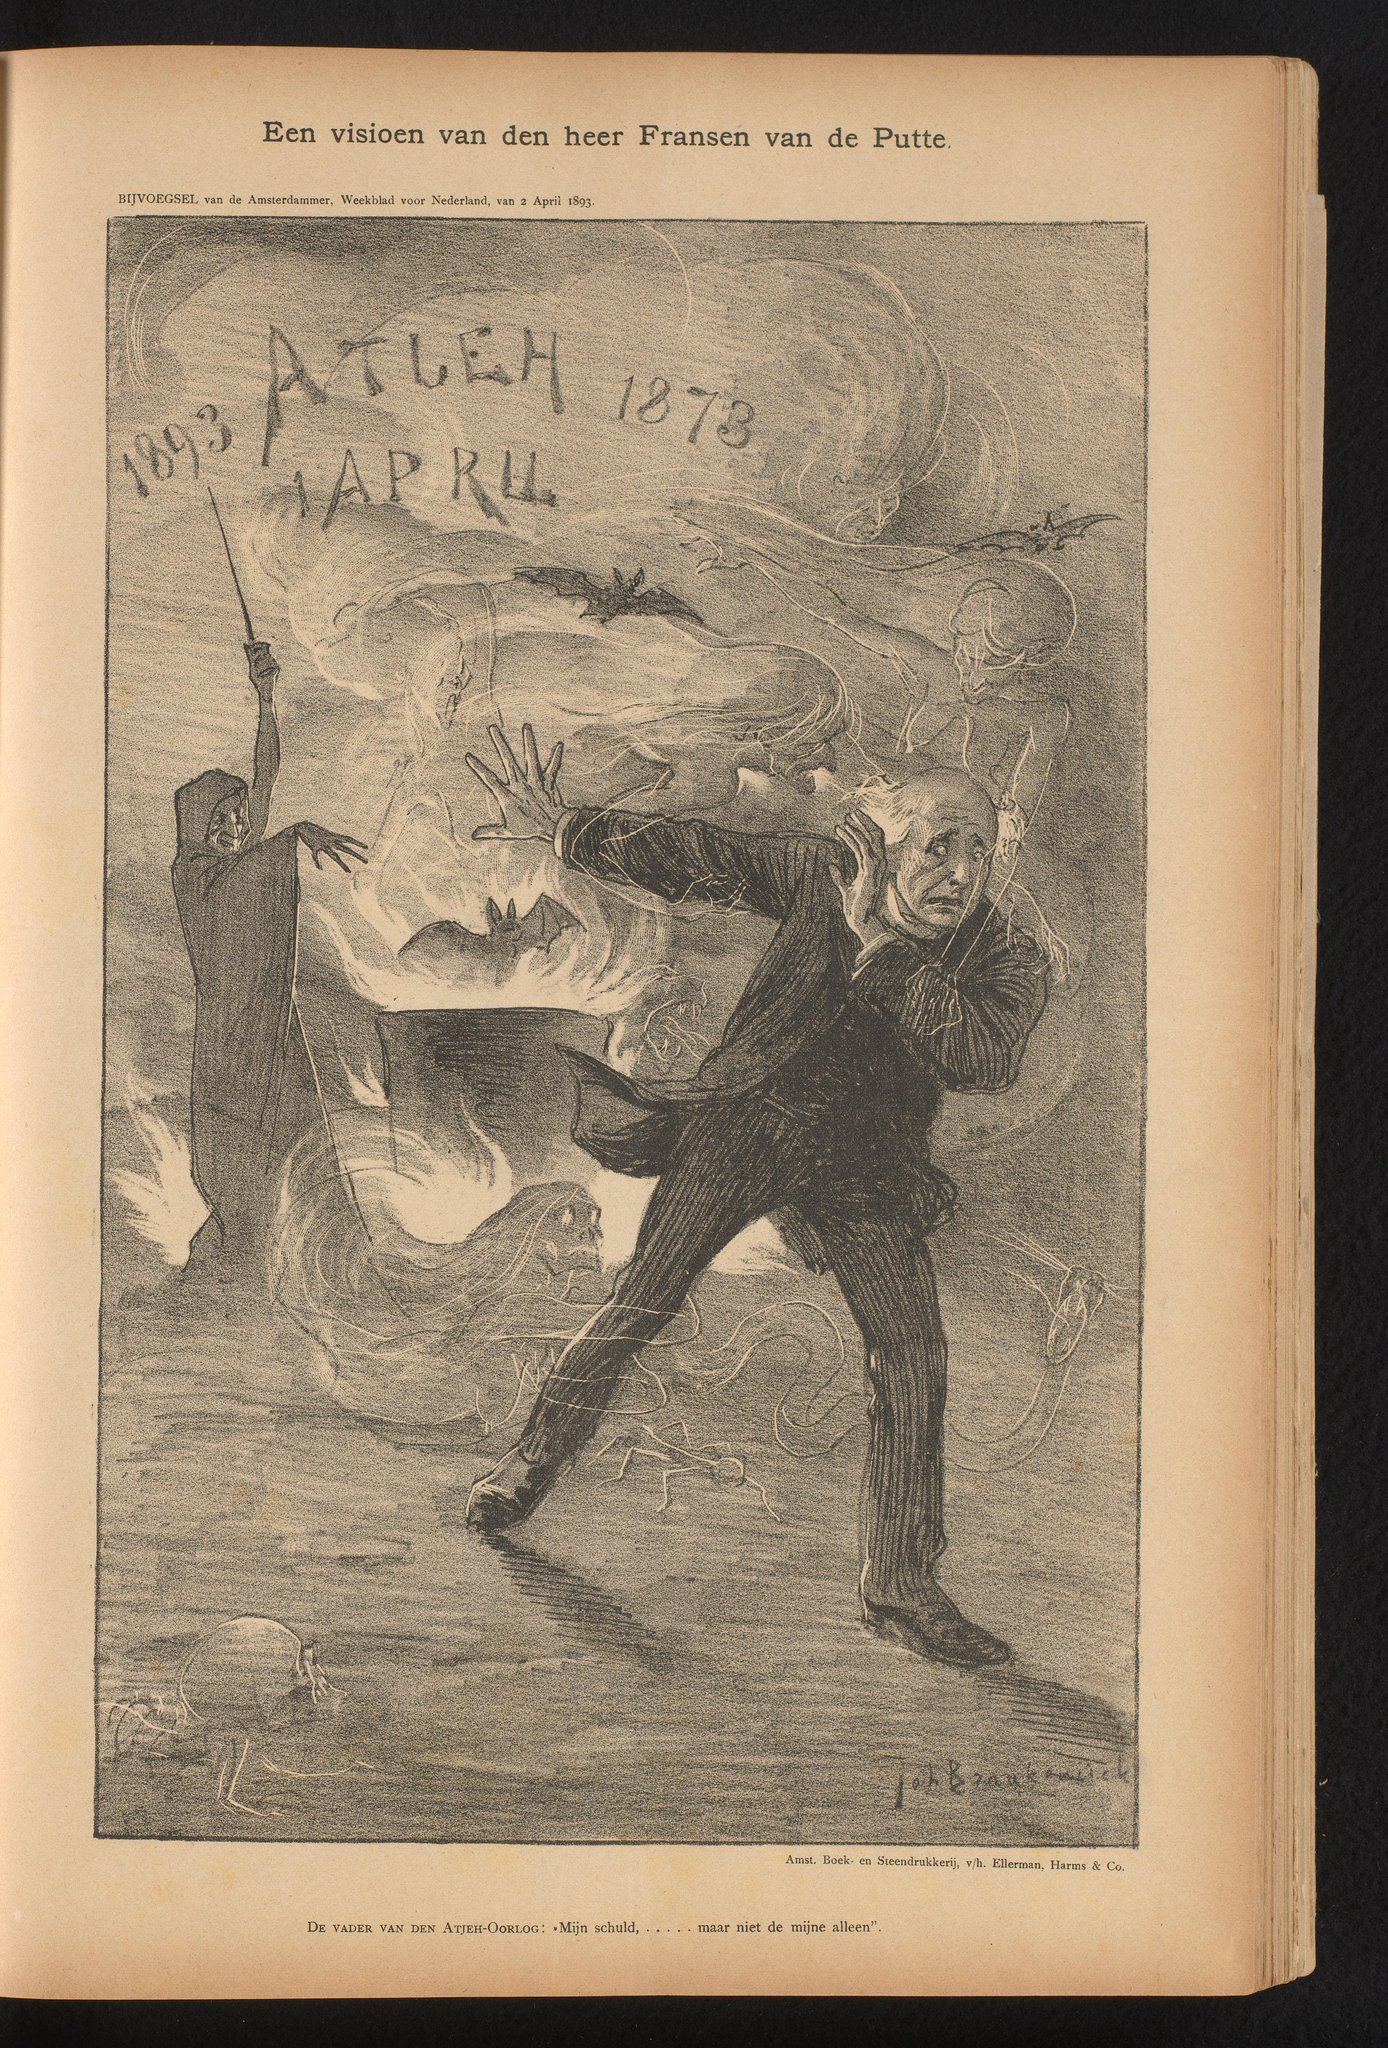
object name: cartoon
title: Een visioen van den heer Fransen van de Putte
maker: johan braakensiek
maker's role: draughtsman, print maker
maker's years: 1858-1940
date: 1893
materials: paper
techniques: lithograph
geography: amsterdam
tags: imperialism, horrors of war, brewing, boiling (in a cauldron); witches' kitchen, political caricatures and satires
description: Voormalig minister van Koloniën Isaäc Dignus Fransen van de Putte achtervolgd door de gruwelen van de oorlog die opstijgen uit een heksenketel. Onder het bewind van minister Van de Putte startte in 1873 de Atjeh-oorlog.